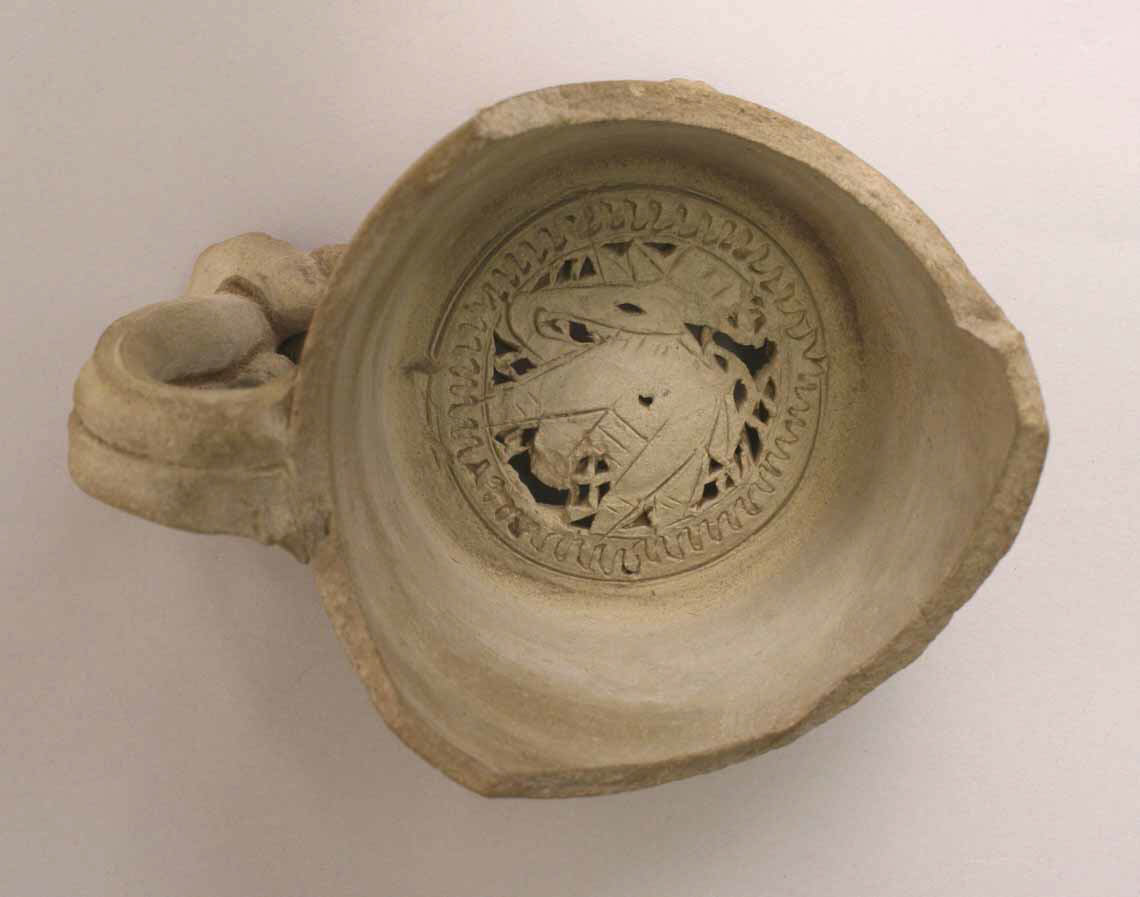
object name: gooleh top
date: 1301-1500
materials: earthenware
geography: egypt